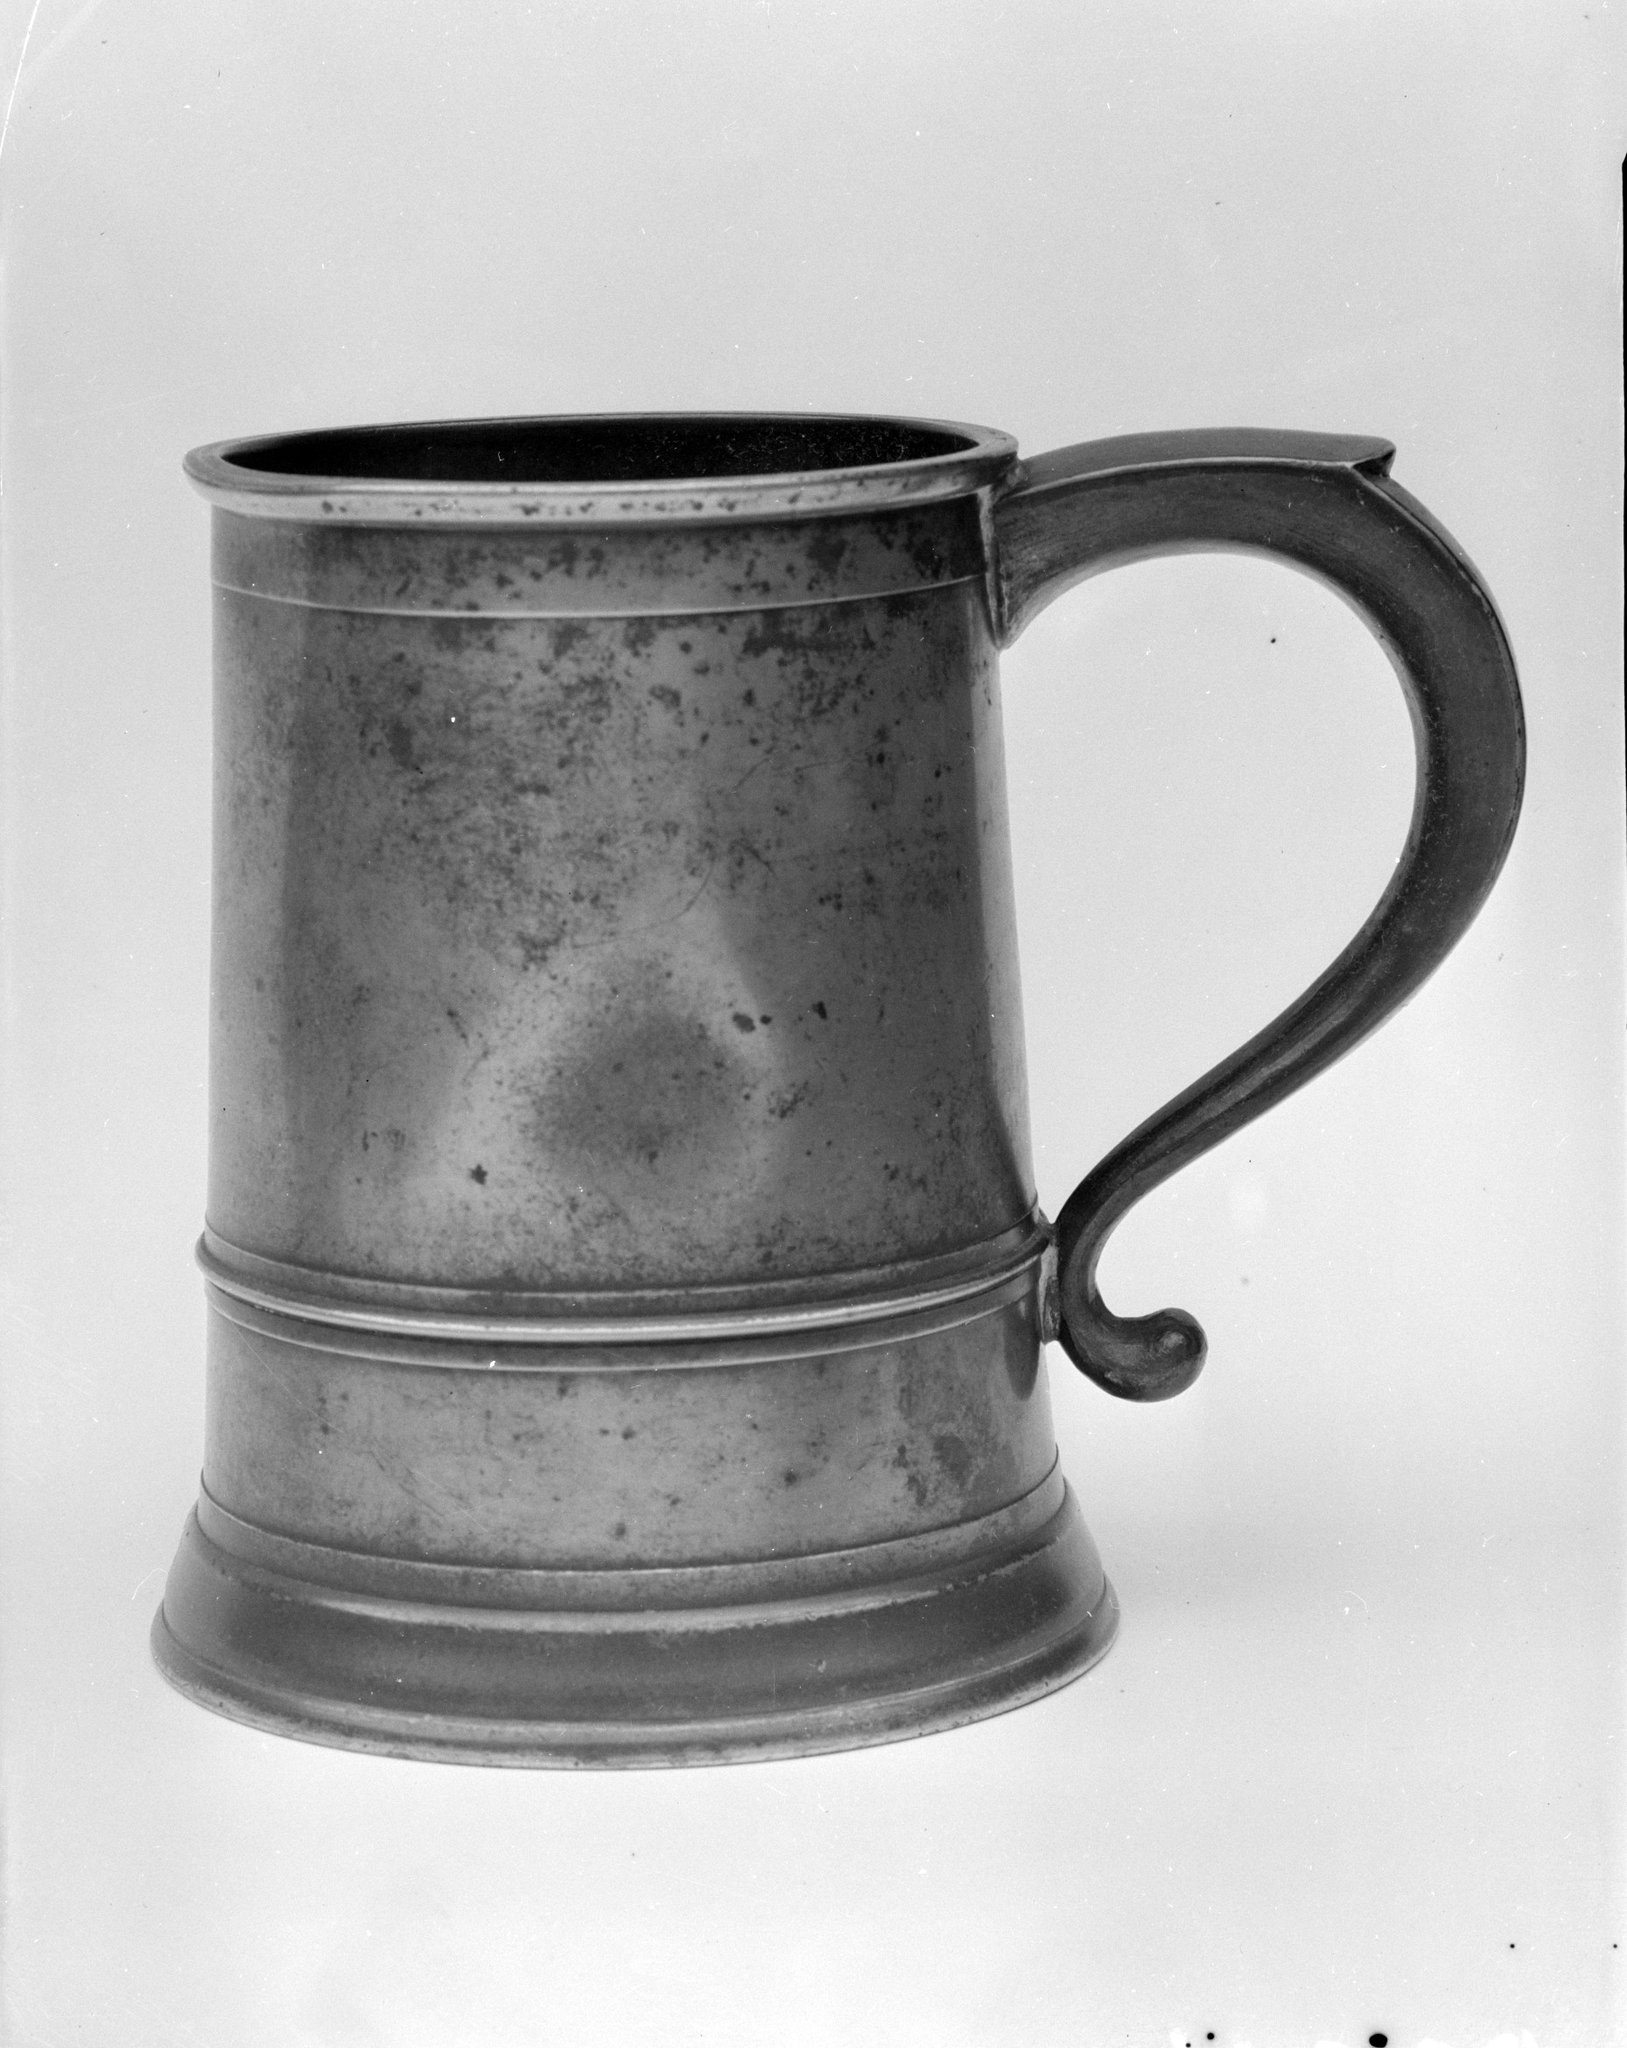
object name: mug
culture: american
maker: thomas danforth boardman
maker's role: maker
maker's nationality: american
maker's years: 1784-1873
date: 1810-1850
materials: pewter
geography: united states